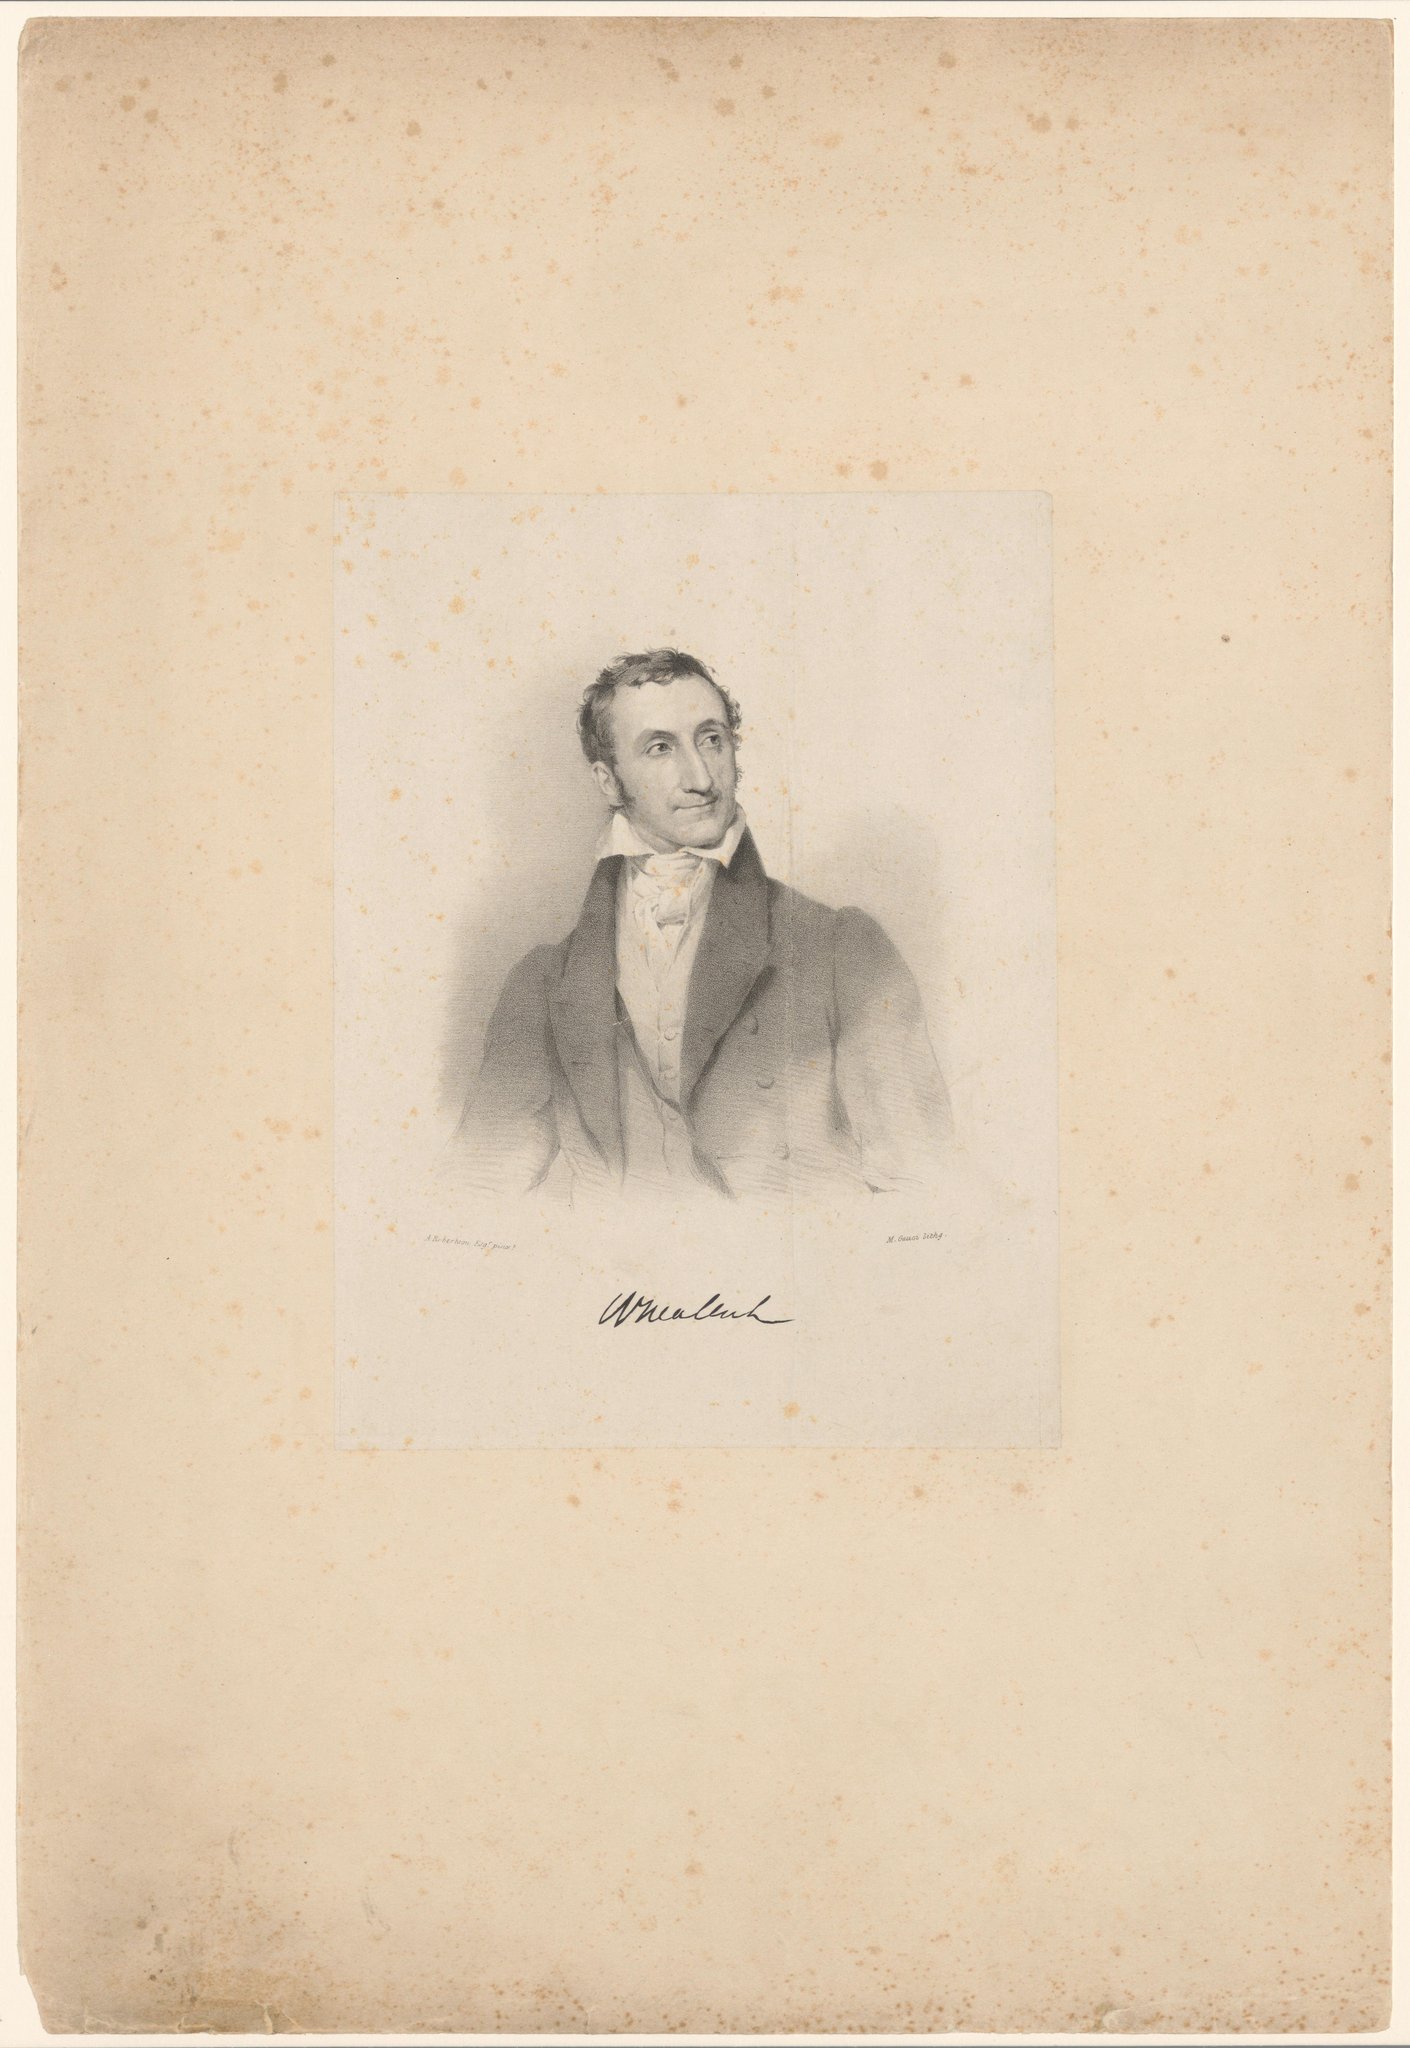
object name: print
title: Portret van Nathaniel Wallich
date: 1820-1840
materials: paper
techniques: lithograph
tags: adult man, historical persons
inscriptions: collector's mark: Lugt 2228